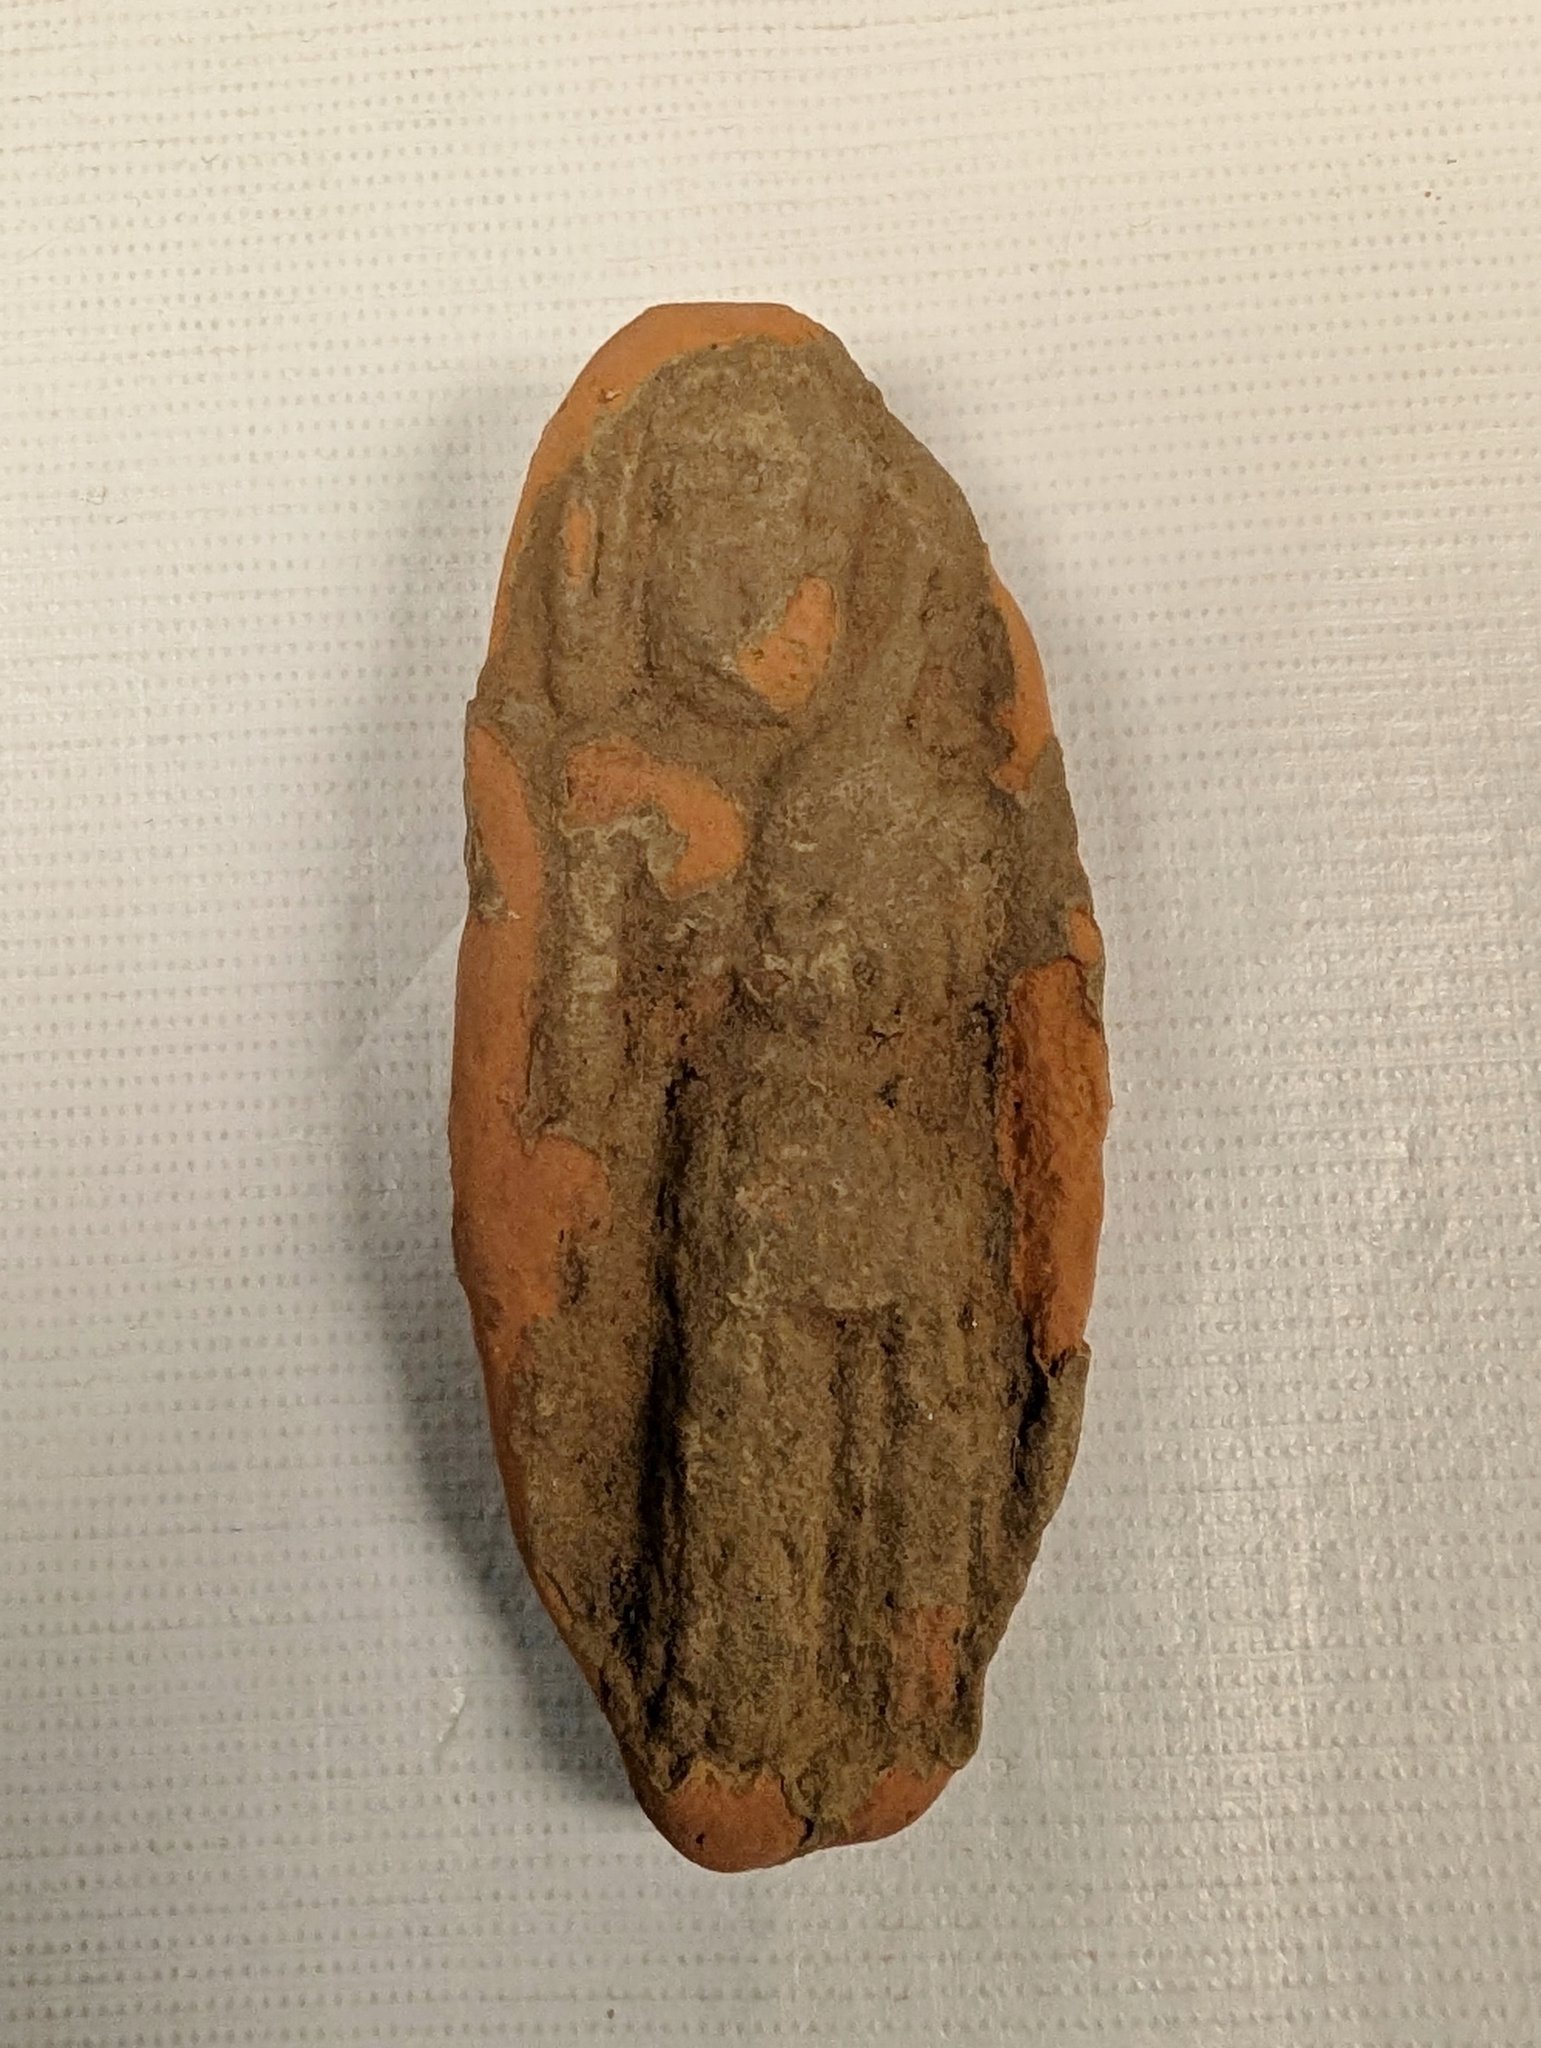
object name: plaque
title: Plaque in the Form of a Female Figure (Study Collection)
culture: pakistani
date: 101-300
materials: terracotta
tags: gandhara